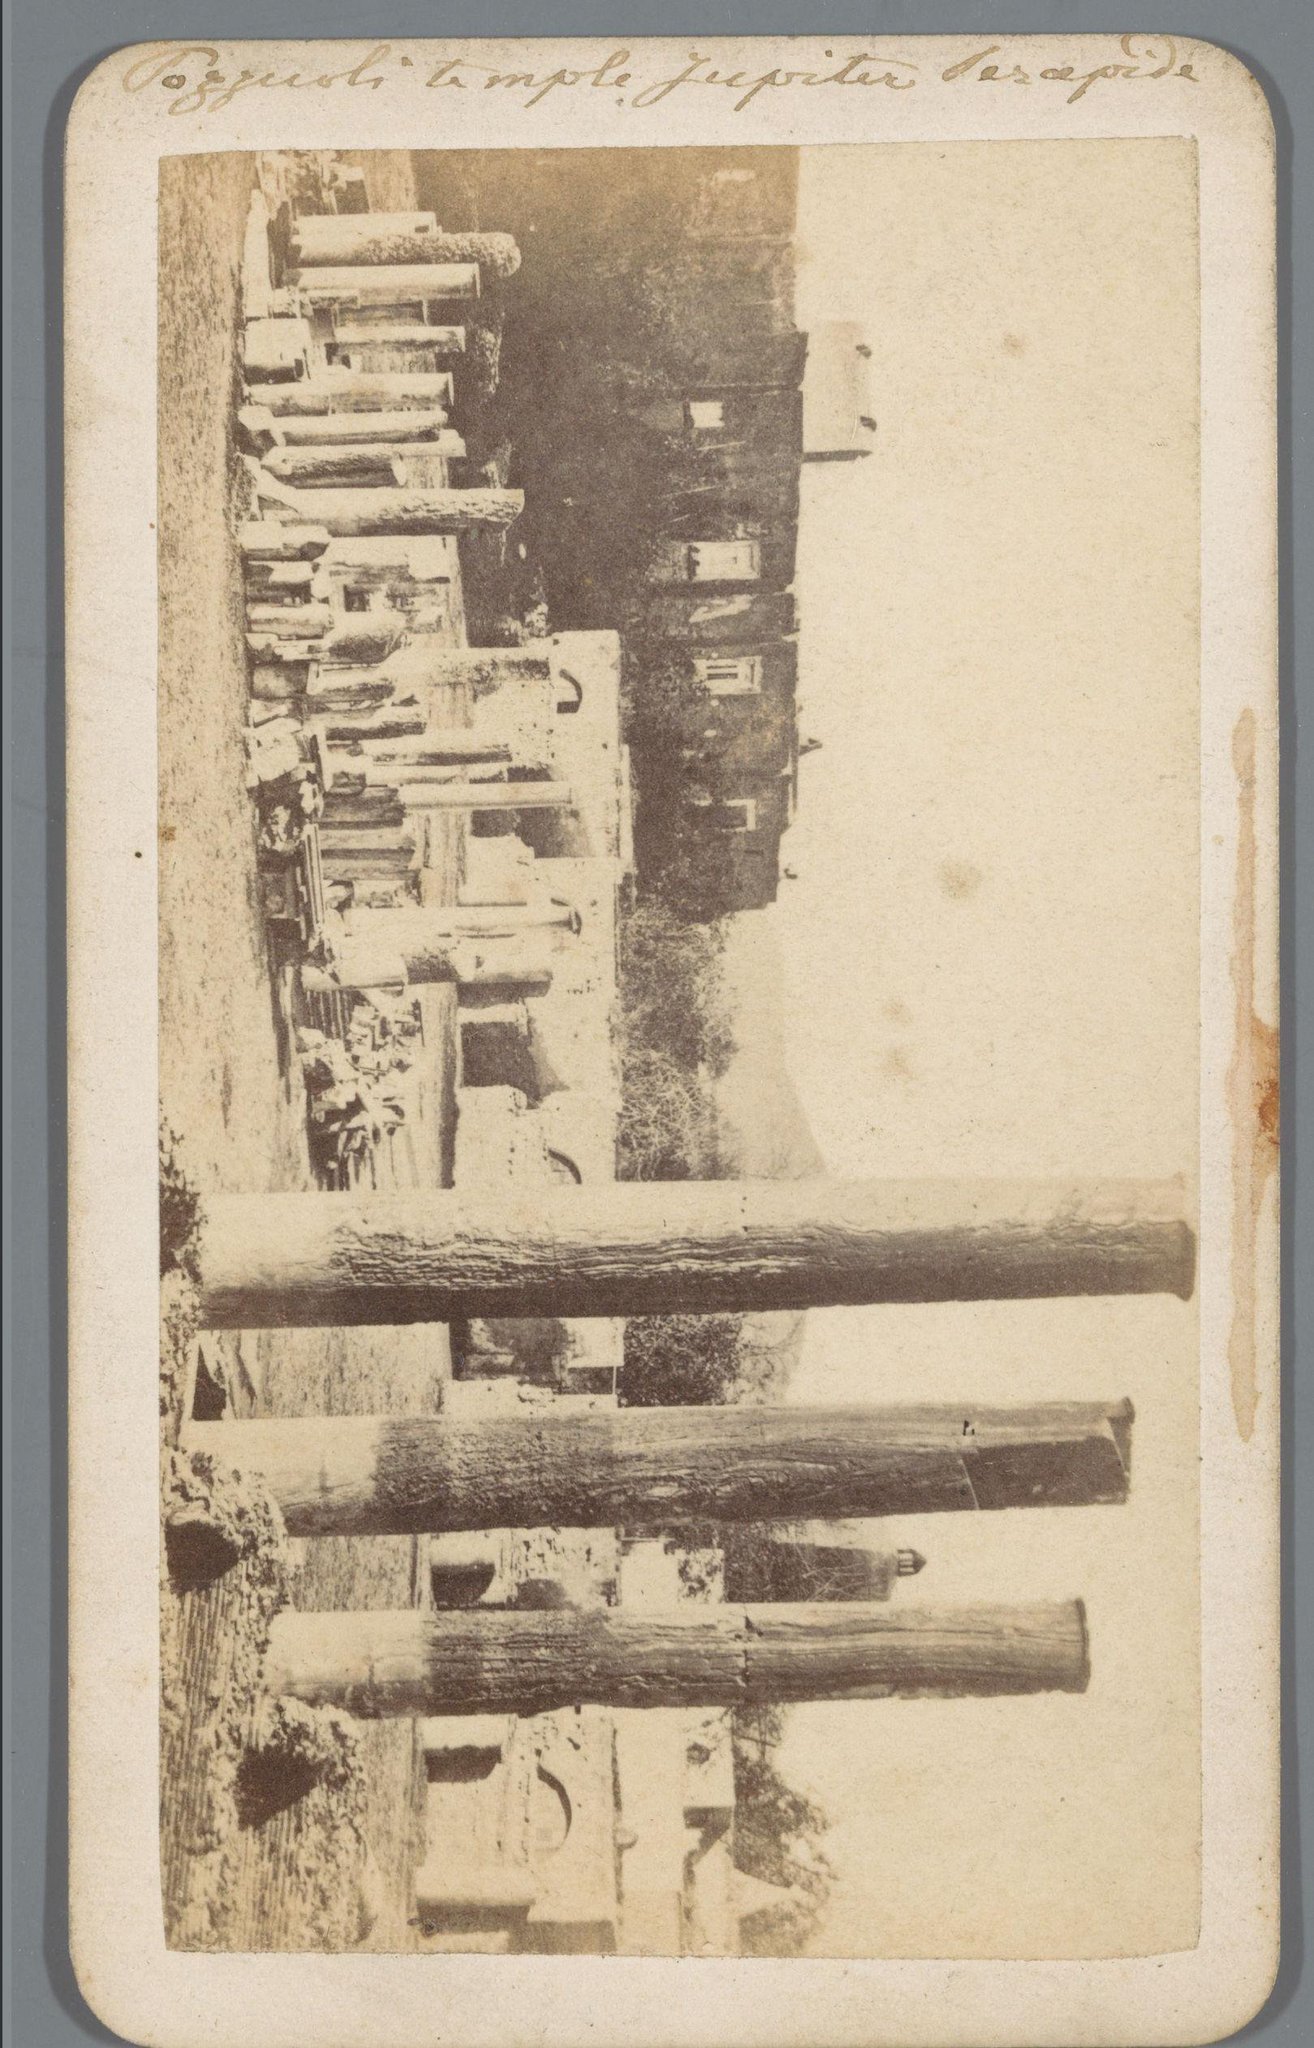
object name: carte de visite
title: Pozzuoli temple Jupiter Serapide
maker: Anonymous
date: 1855-1885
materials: cardboard, paper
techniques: albumen print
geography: pozzuoli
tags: ruin of a building ~ architecture, excavation ~ archaeology, pozzuoli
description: De resten van het Macellum zijn lang ten onrechte aangezien voor de overblijfselen van een tempel van Jupiter Serapis.